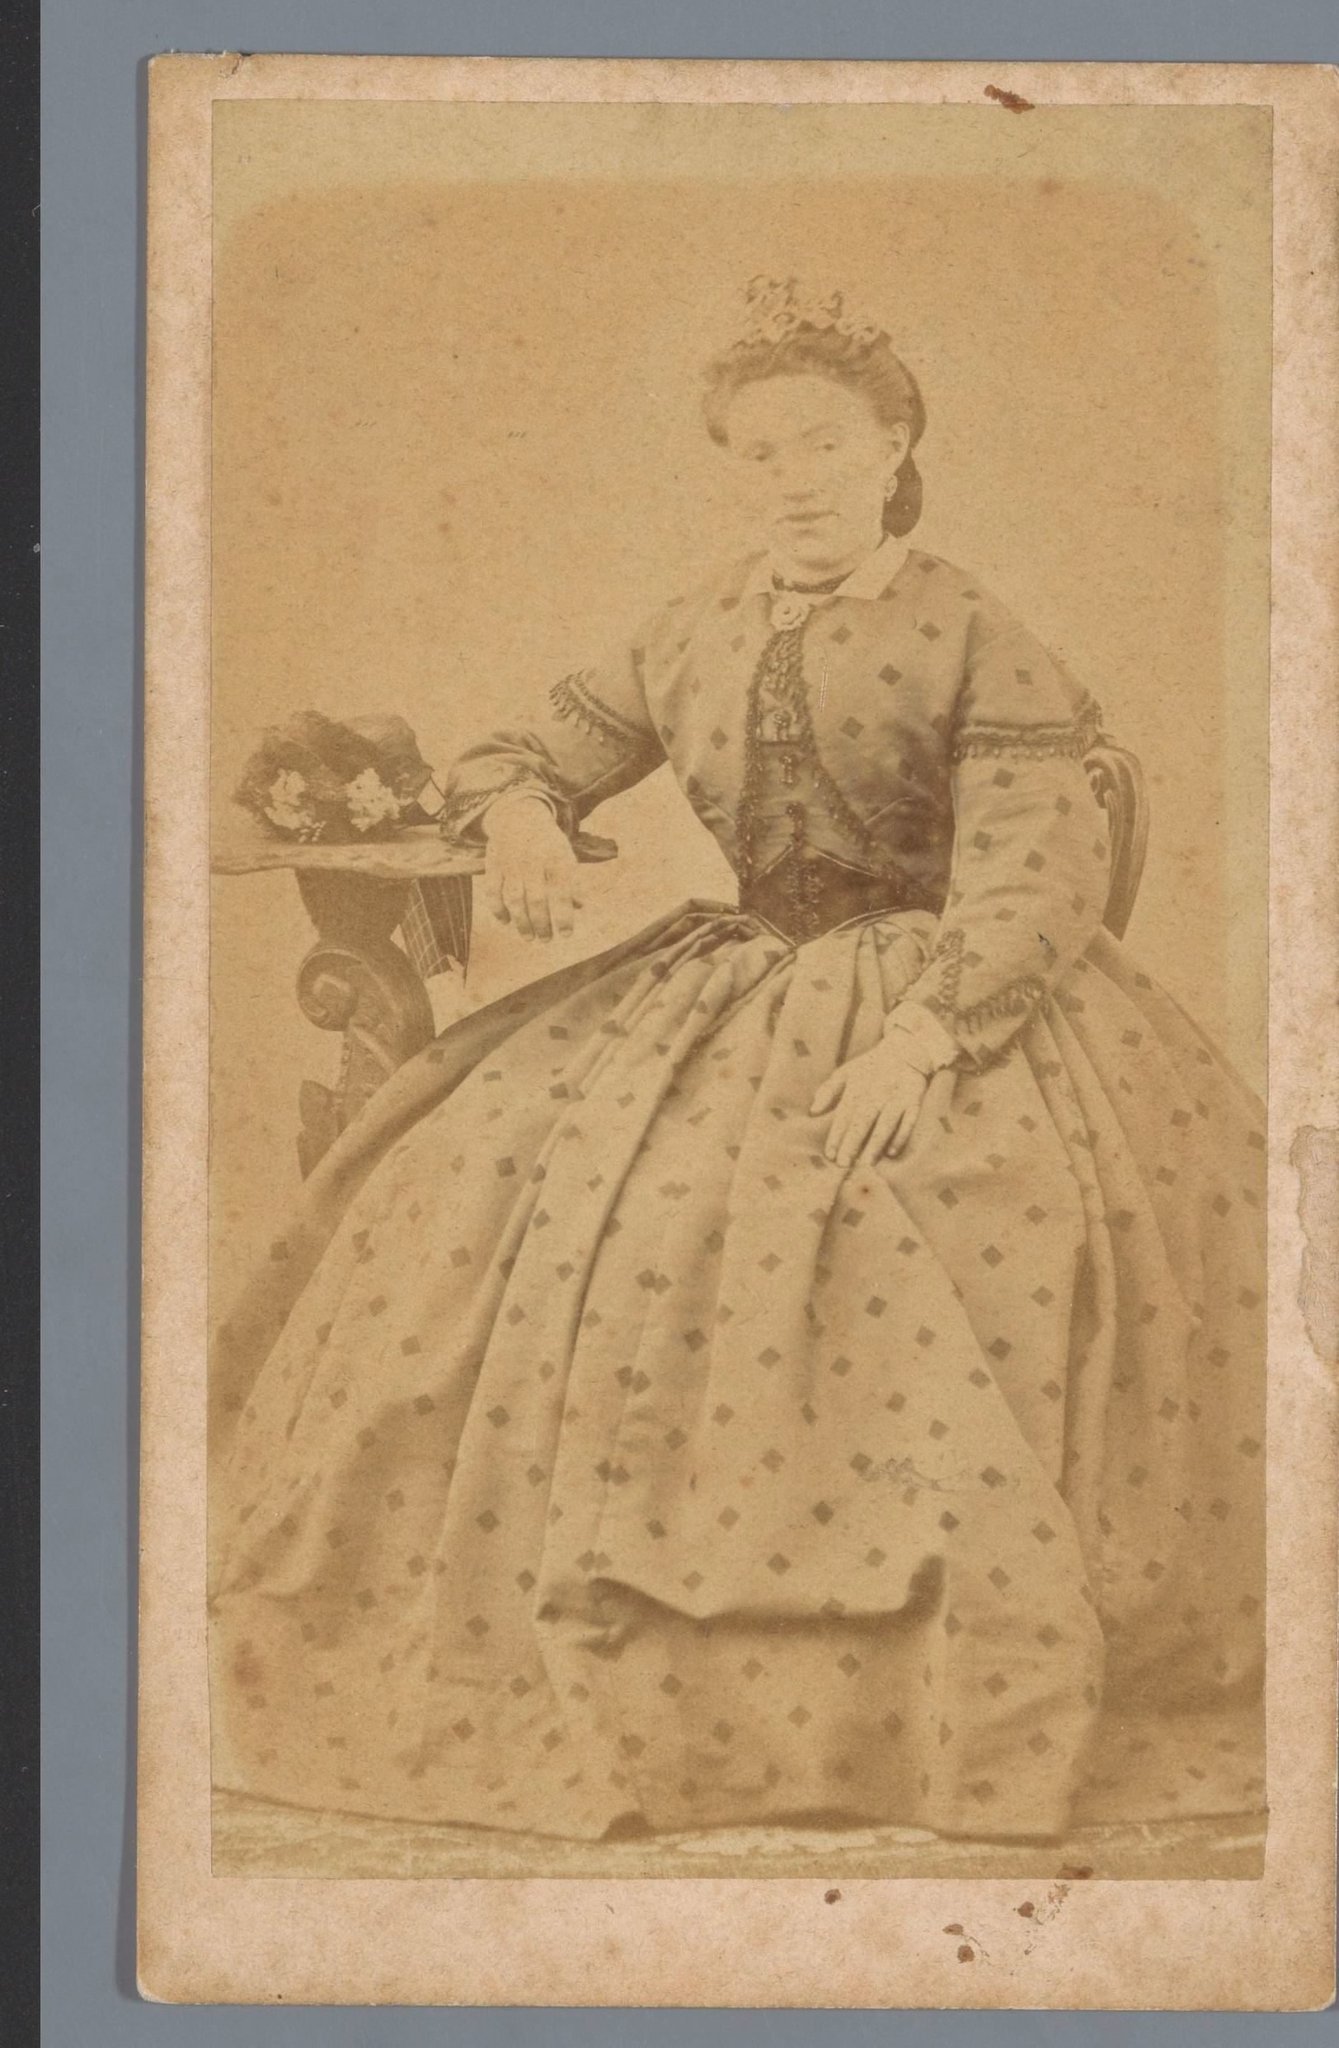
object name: photograph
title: Portret van een onbekende vrouw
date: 1864-1900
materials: cardboard, photographic support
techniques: albumen print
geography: terneuzen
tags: historical persons not known by name - bb - woman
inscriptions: inscription: ‘P.F. Standaer[...]/ Artiste Photogra[...]/ TERNEUZEN’